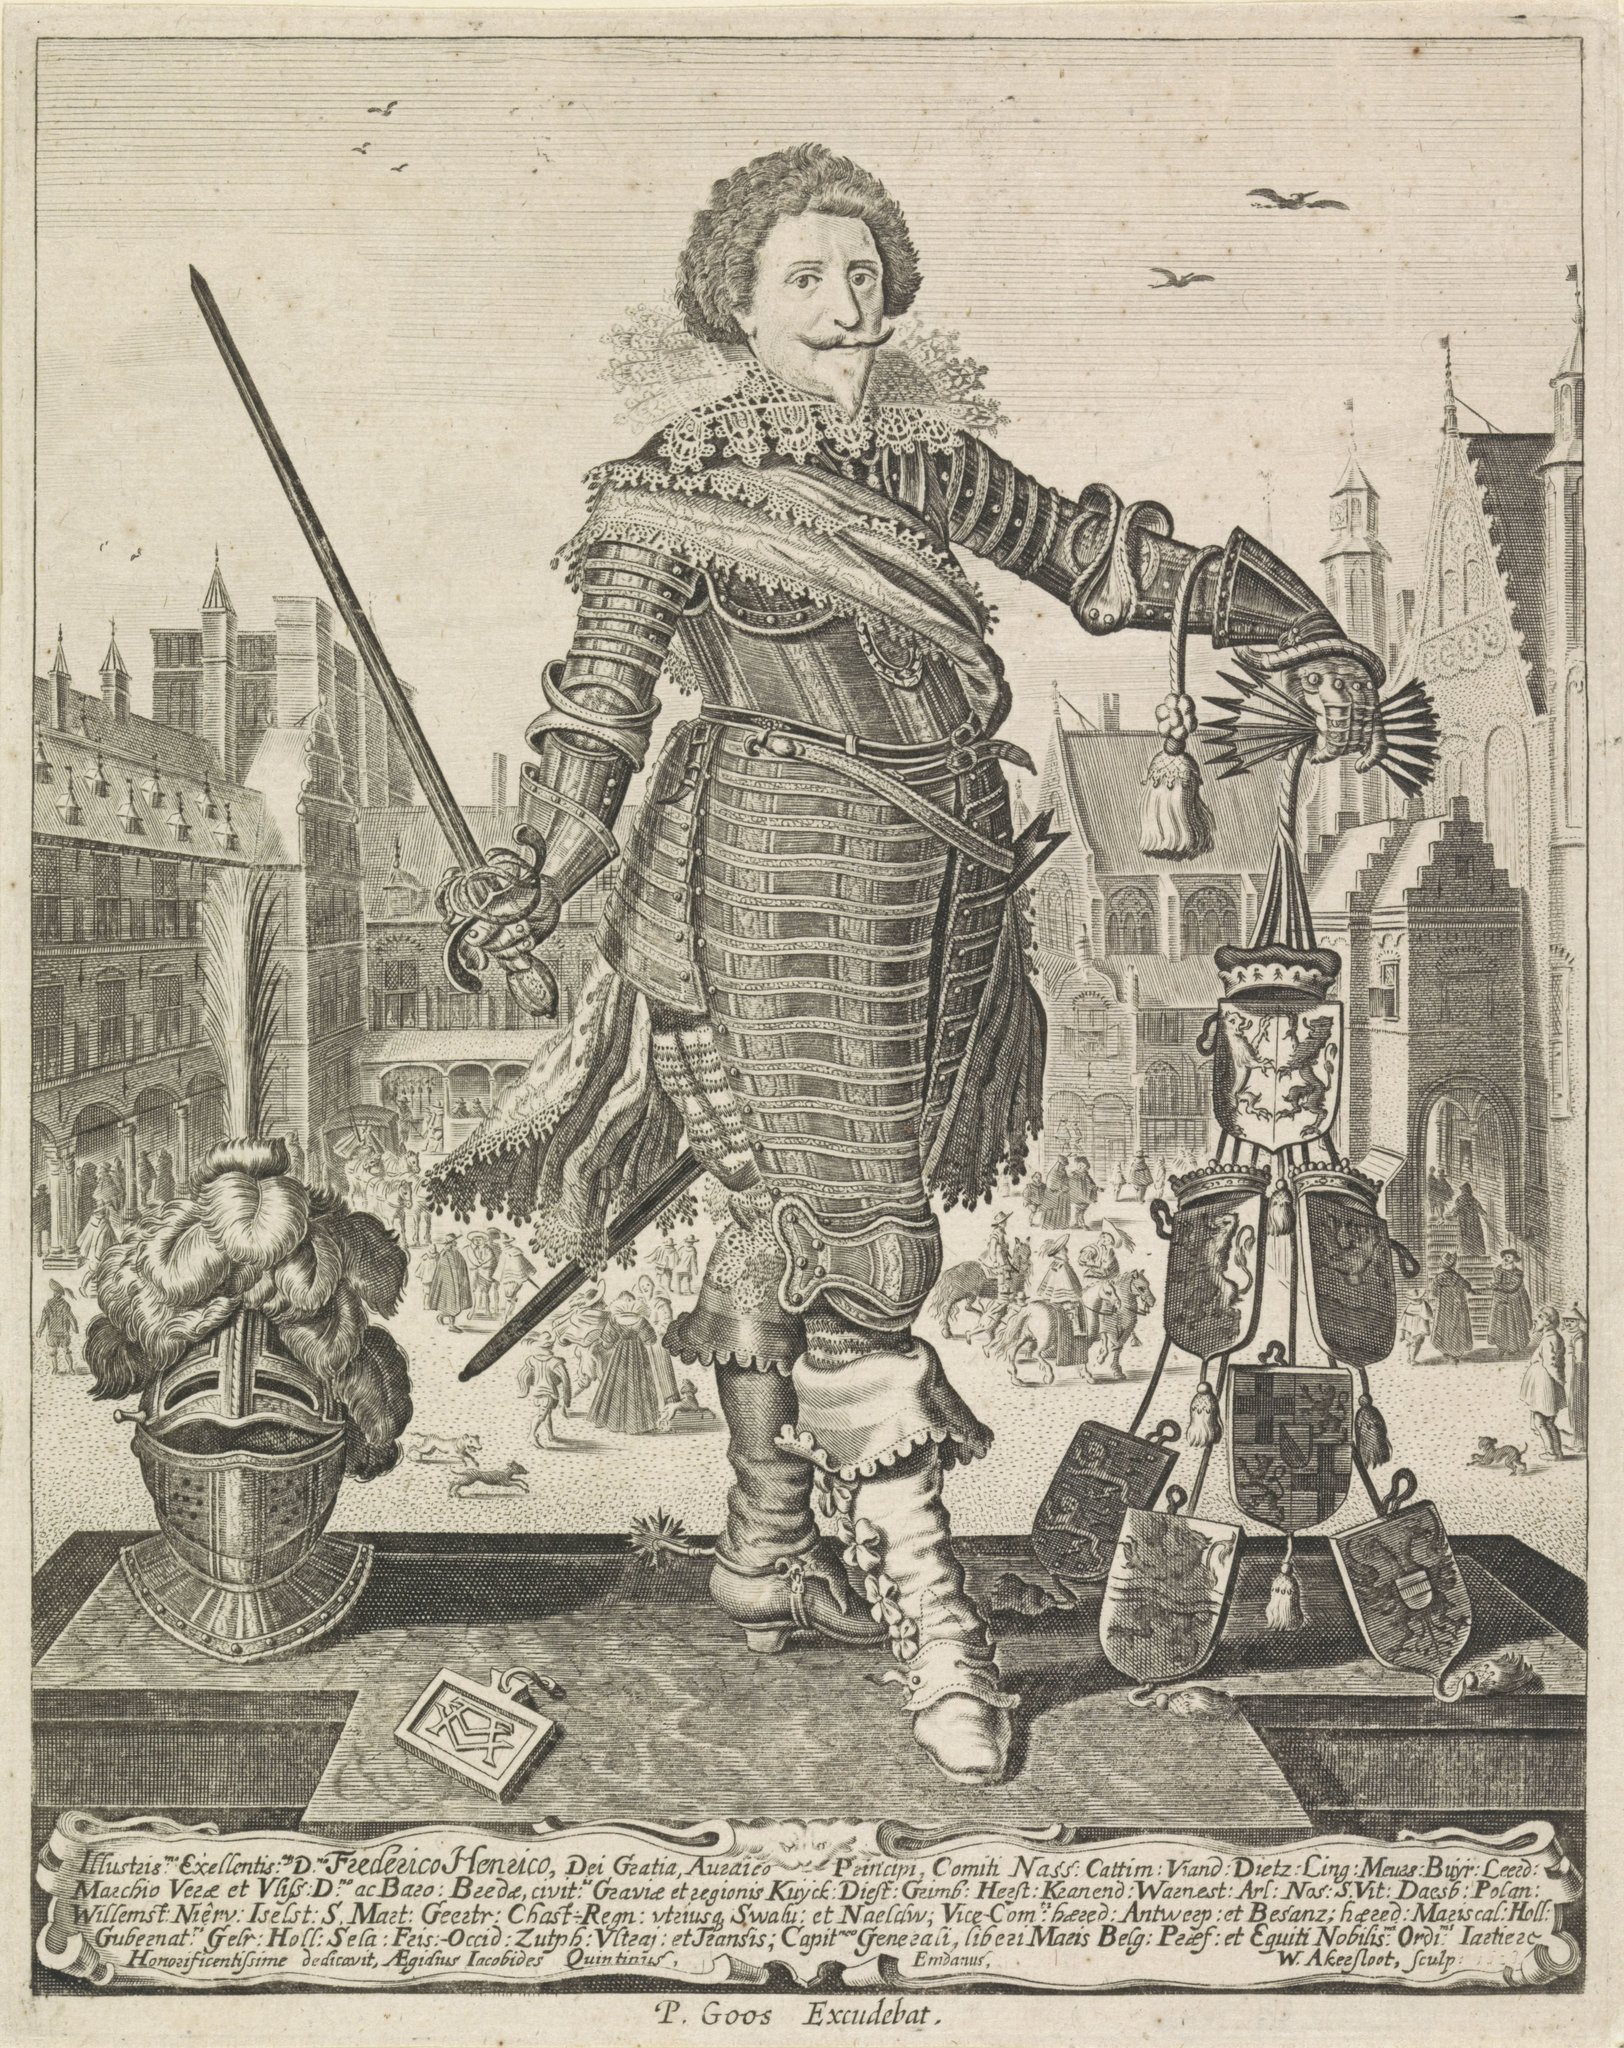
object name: print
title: Portret van Frederik Hendrik, prins van Oranje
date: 1628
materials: paper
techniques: engraving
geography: northern netherlands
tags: delft, the hague, frederick henry (prince of orange)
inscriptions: collector's mark: Lugt 2228, collector's mark: Lugt 963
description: Portret van Frederik Hendrik, ten voeten uit in wapenrusting, staande op een bordes. In zijn rechterhand een degen, in zijn linker een bundel pijlen en een touw. Aan het touw zijn de wapens van de Zeven Provinciën vastgemaakt. Op de achtergrond het bevolkte Binnenhof te Den Haag. In een cartouche vier regels Latijnse tekst.